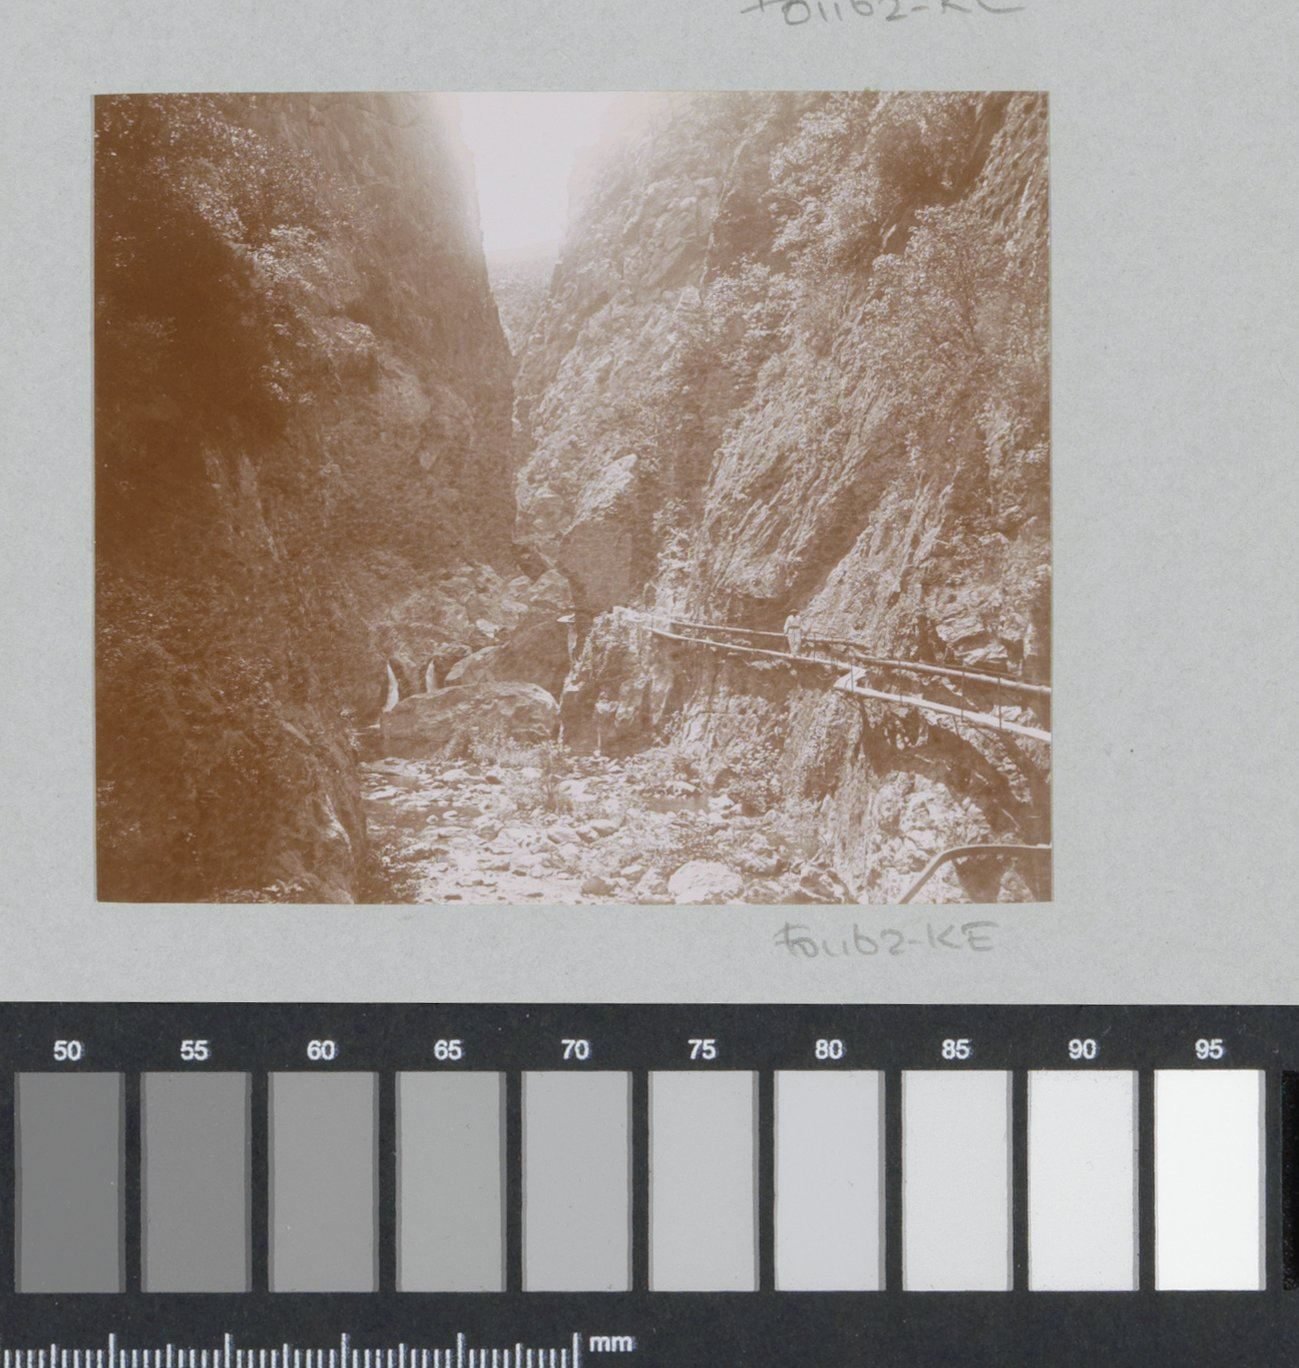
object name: photograph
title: Bergkloof met rechts een wandelaar op een plankier, vermoedelijk in de Pyreneeën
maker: Anonymous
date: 1905-1910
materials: paper, photographic support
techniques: gelatin silver print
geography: pyrenees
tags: walking, hiking (recreation), ravine, chasm, abyss, canyon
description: Onderdeel van Fotoalbum van een Franse amateurfotograaf met bezienswaardigheden in Frankrijk, Zwitserland en Italië.